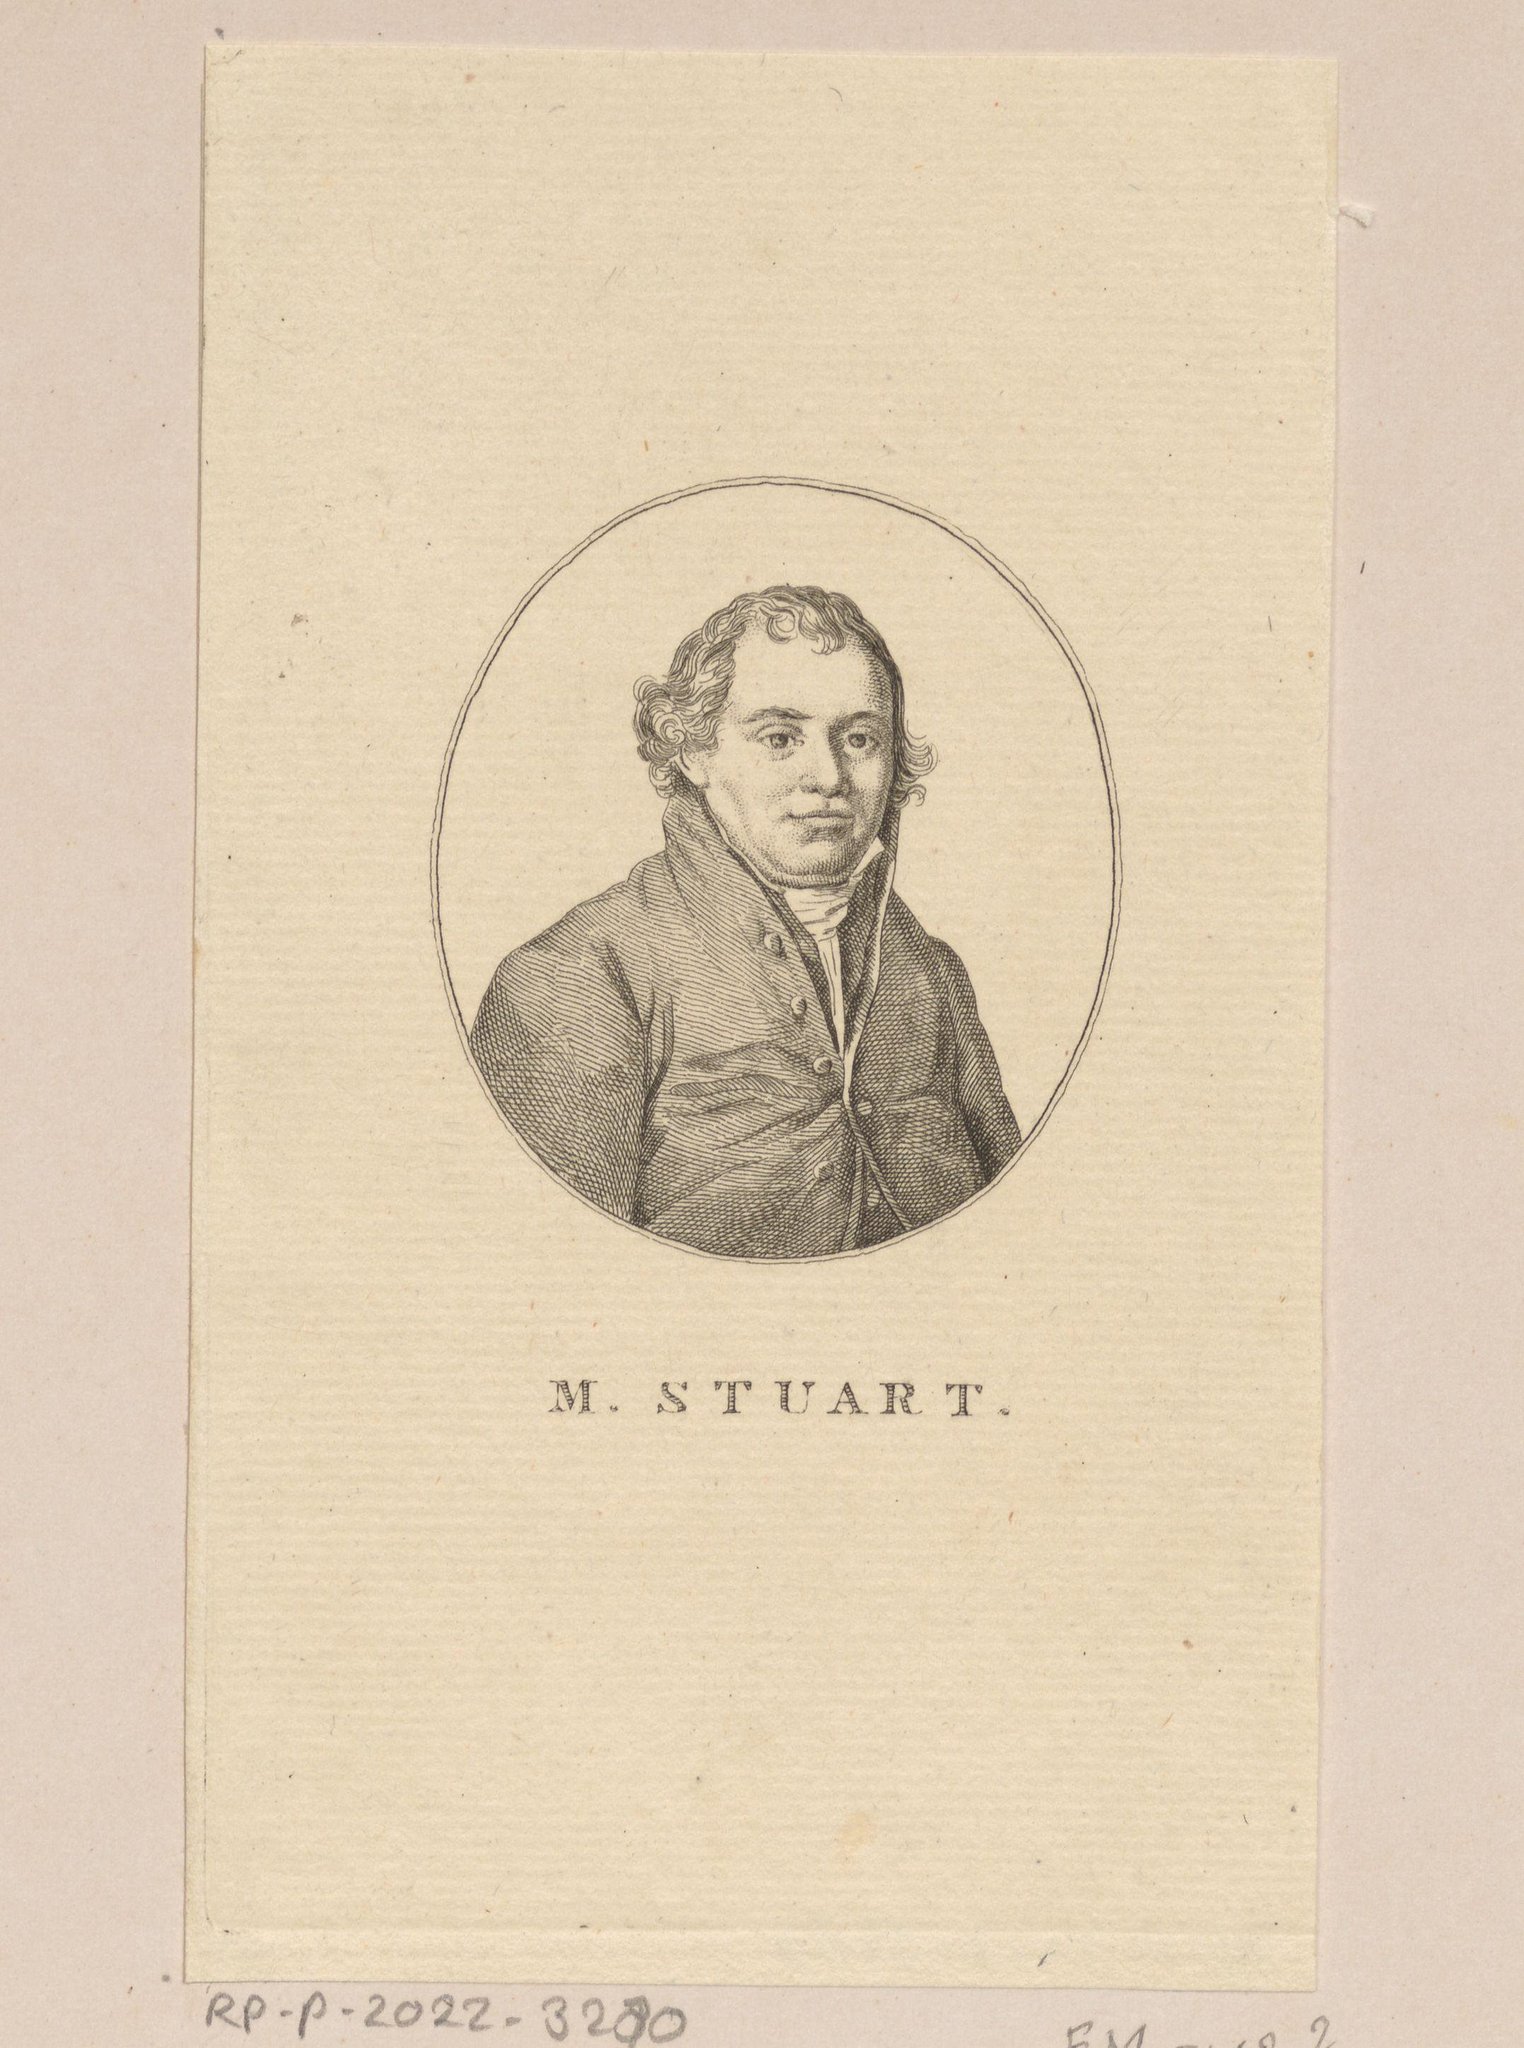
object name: print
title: Portret van Martinus Stuart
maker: willem van senus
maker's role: painter, print maker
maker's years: 1773-1851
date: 1810-1818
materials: paper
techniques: etching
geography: netherlands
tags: rotterdam, historical persons, writer, poet, author